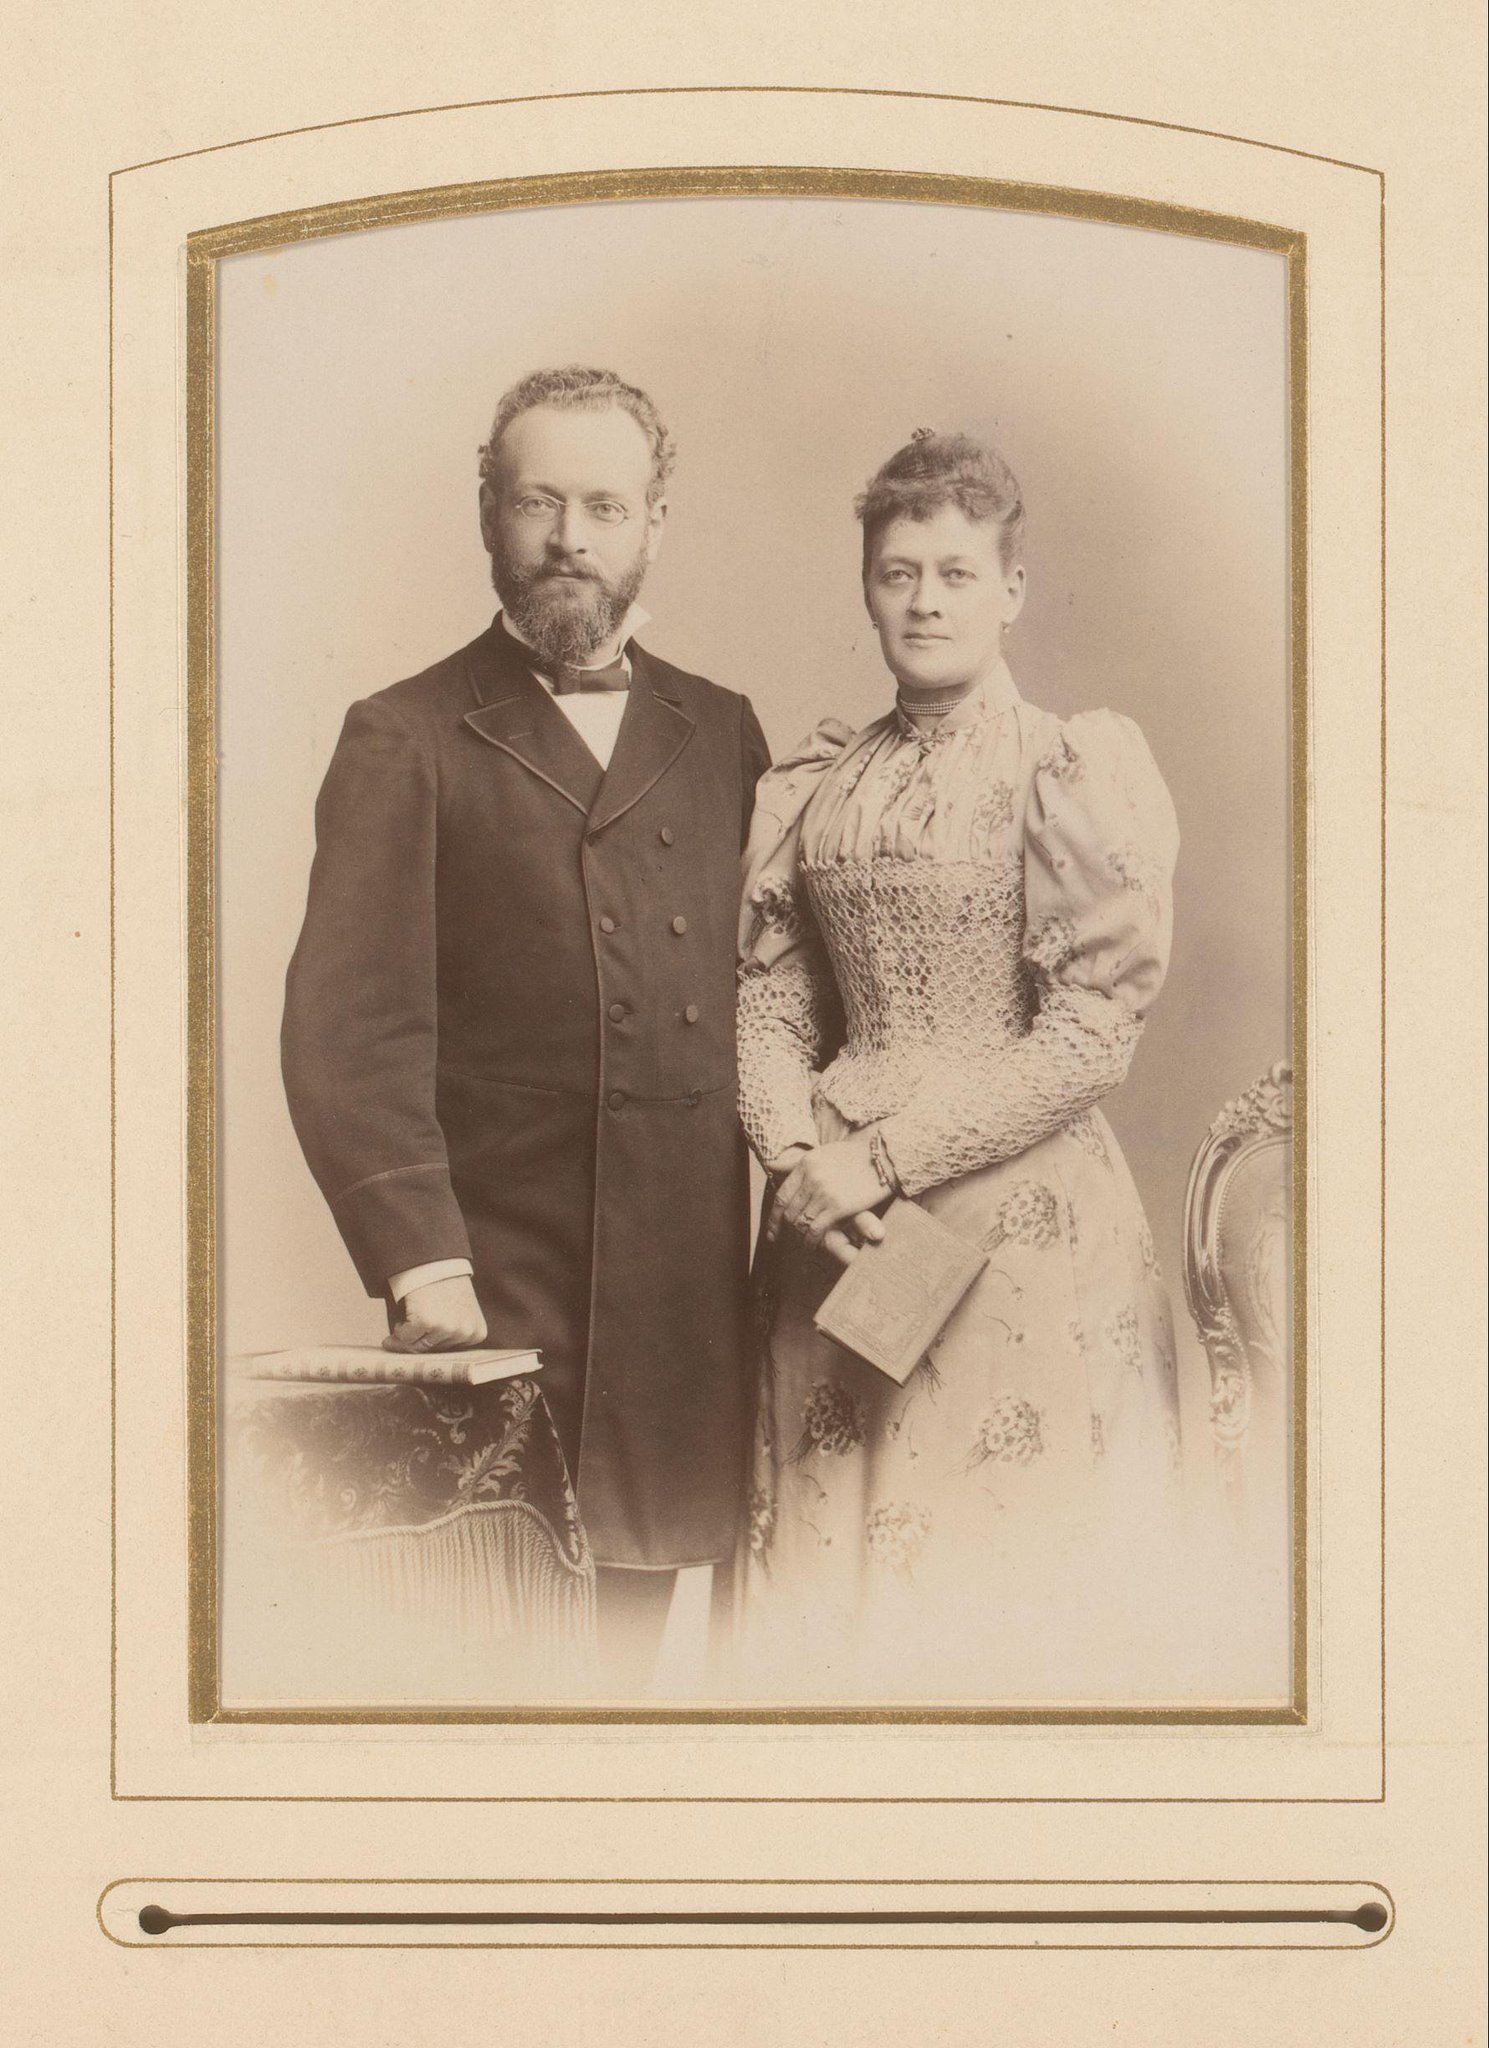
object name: photograph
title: Portret van een man en een vrouw met boek in de hand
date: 1850-1900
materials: cardboard, photographic support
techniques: albumen print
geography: berlin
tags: historical persons - bb - woman, historical persons, book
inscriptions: inscription: ‘Photographisches/ Atelier/ Junk & Schultz/ Berlin/ Leipziger-Str 35./ Ecke Charlotten-Str./ Sommer 1892./ Bilder in allen Grössen, Vergrösserungen./ Gruppenbilder u. Landschaften./ Die Platte bleibt für Nachbestellungen aufbewahrt.’, annotation: ‘Sumilia Ehrher[..]/ zur frdl. Erinnerung von/ [...] Sommer 1892/ [Paul Grafs] & [S...i]’